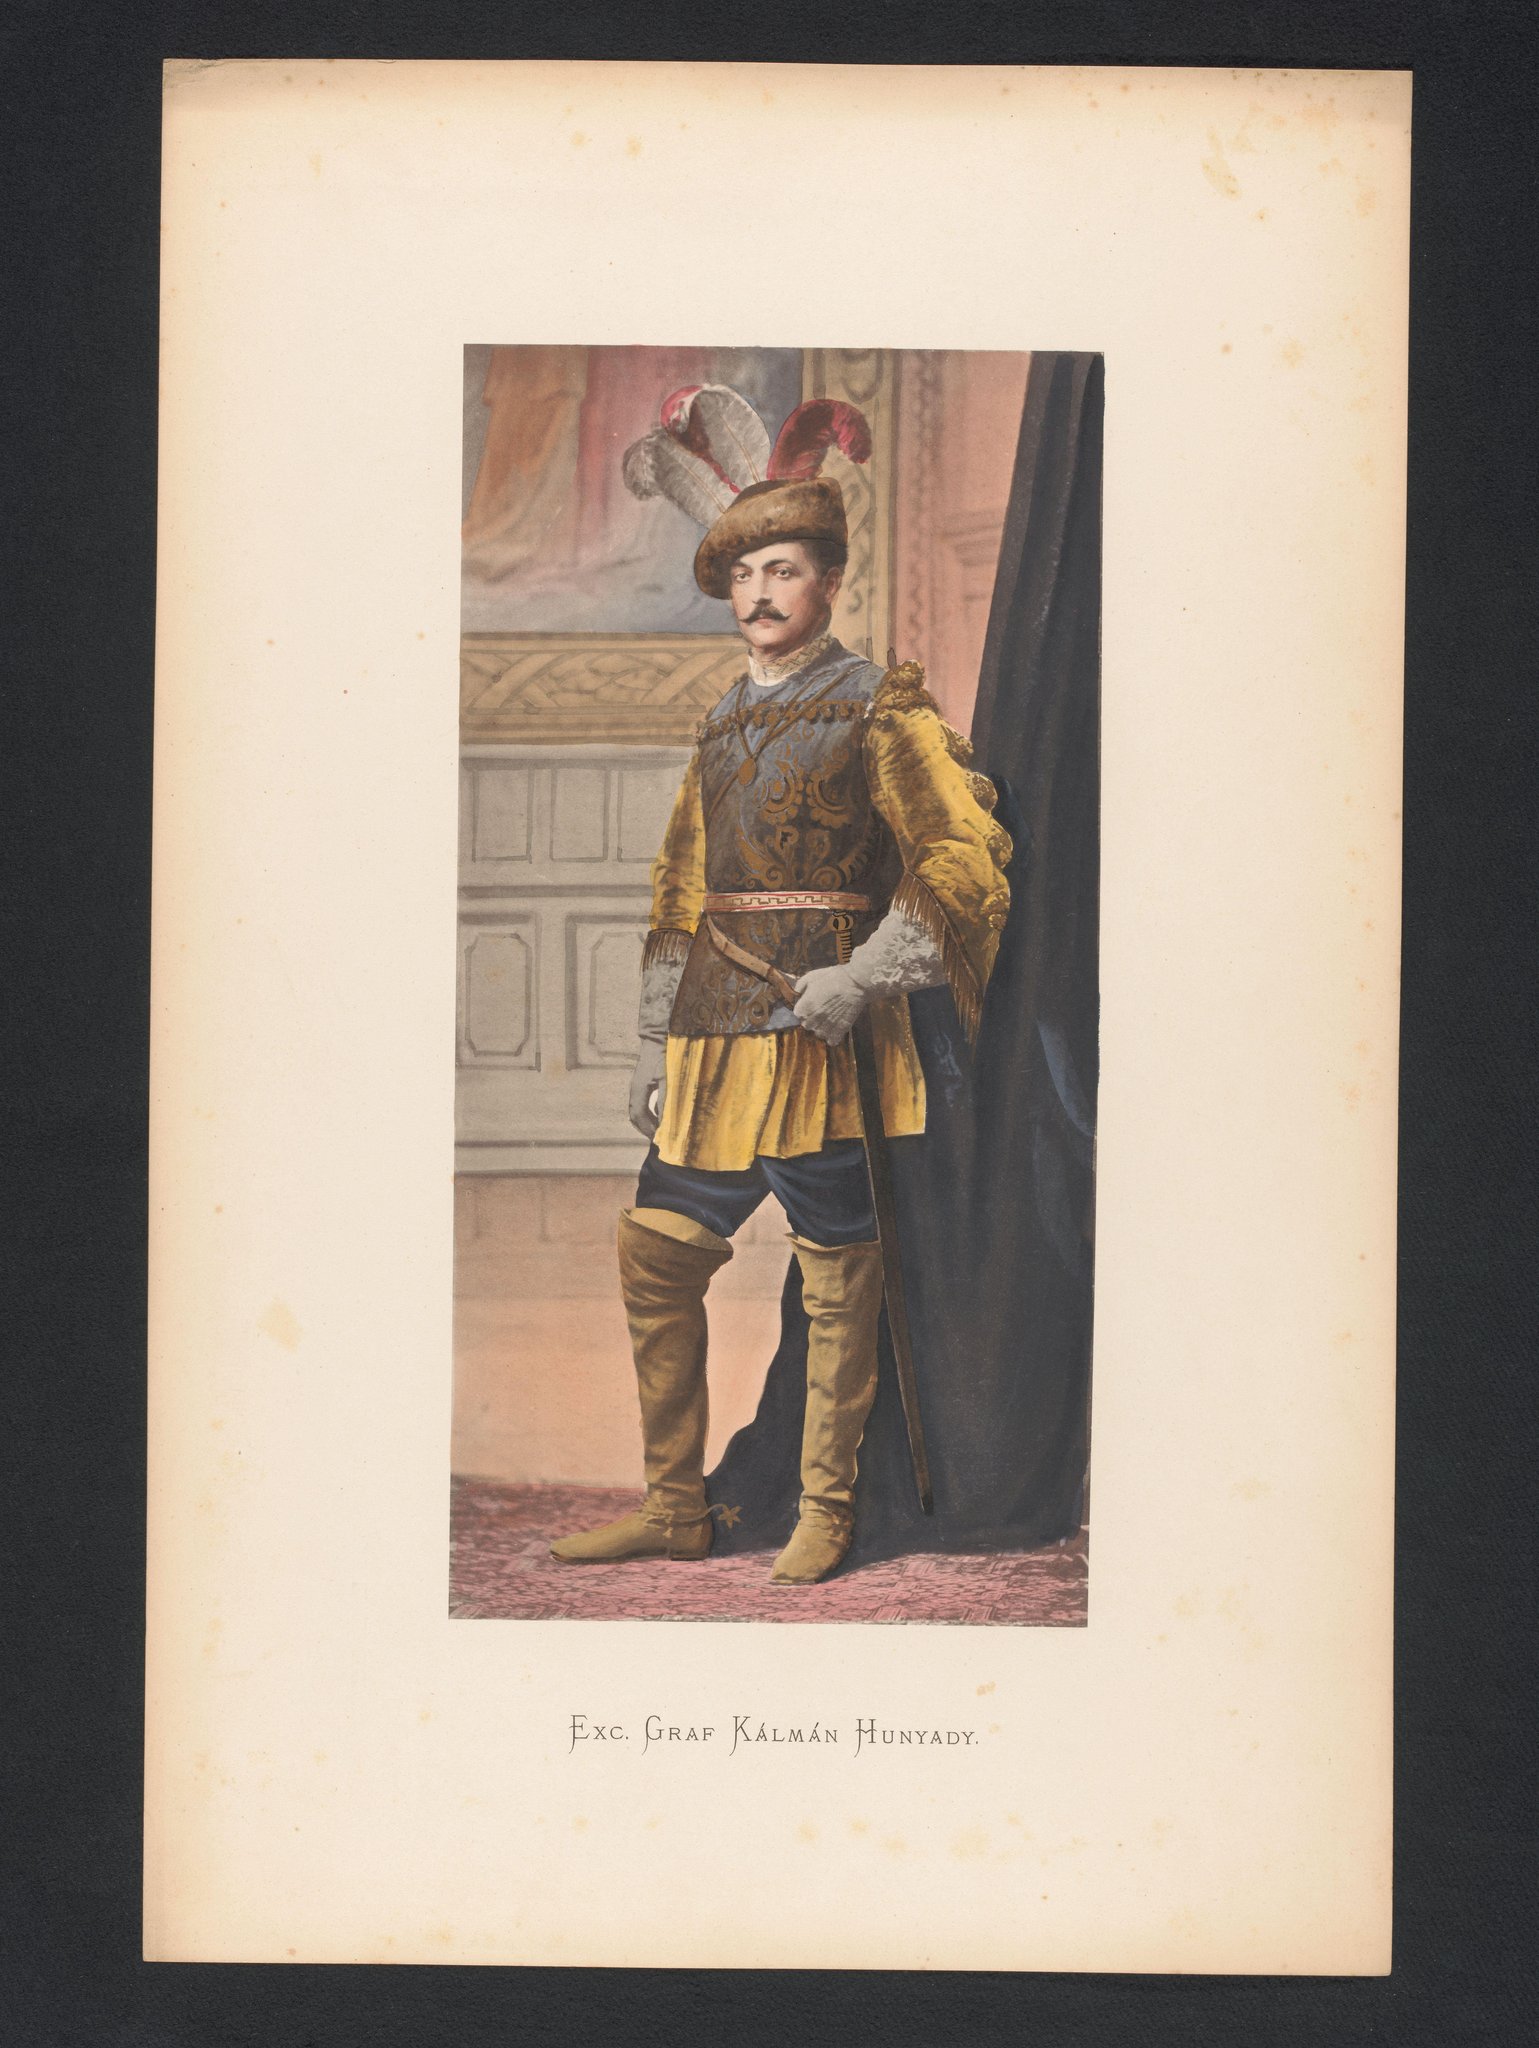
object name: photomechanical print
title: Portret van graaf Kálmán Hunyady de Kéthely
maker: Anonymous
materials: paper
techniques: photograph, hand coloring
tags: vienna, earl, aristocracy; 'aristocratia' (ripa), historical persons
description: Deze prent maakt deel uit van een omslag met 86 prenten op 78 bladen en 11 tekstbladen.